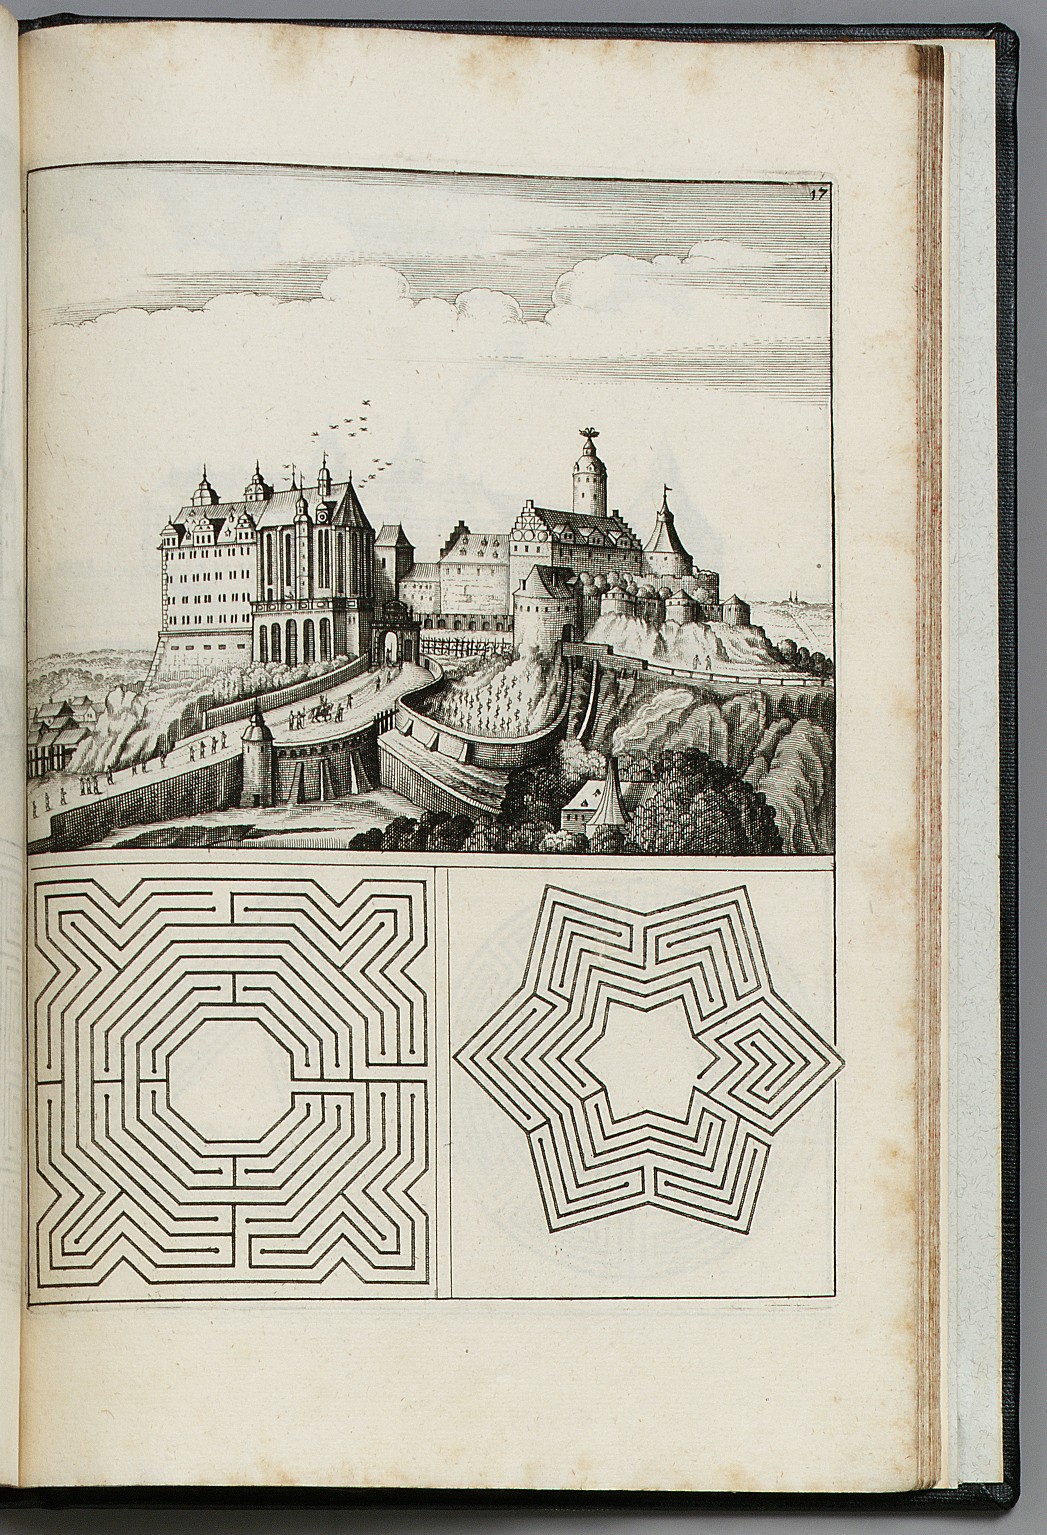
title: Architectura Curiosa Nova: Das ist, neue ergotzliche Sinn und Kunstreiche auch nutzliche Bau- und Wasser-Kunst . . .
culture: german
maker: georg andreas böckler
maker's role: author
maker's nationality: german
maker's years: 1644-1698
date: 1664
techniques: engraving, printing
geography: nuremberg